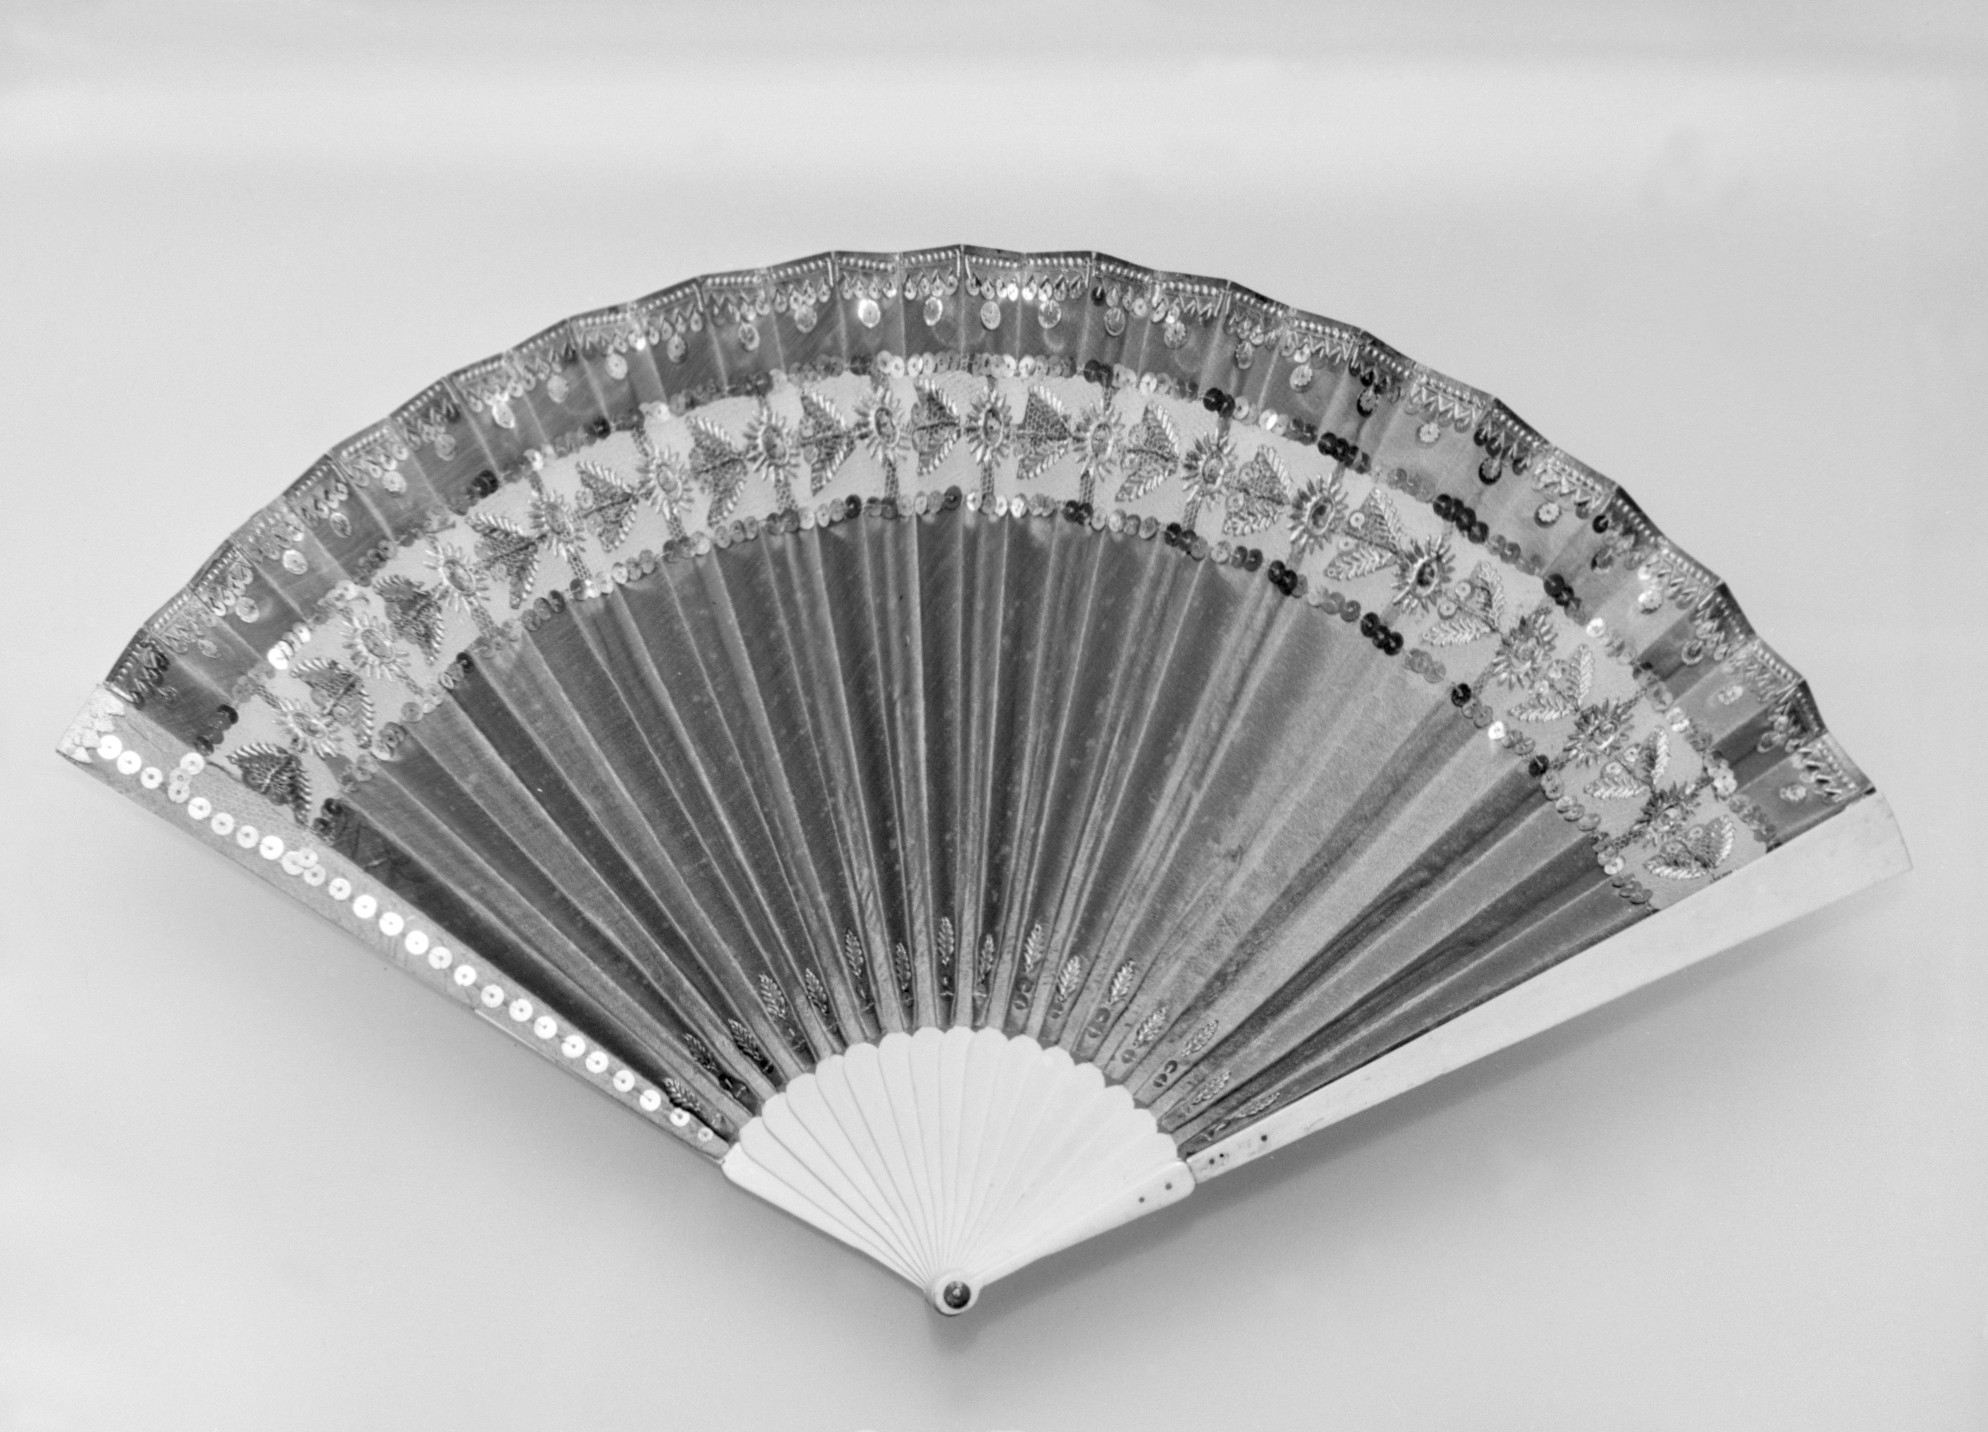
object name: fan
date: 1800-1833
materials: brass, ivory, metal, paper, silk